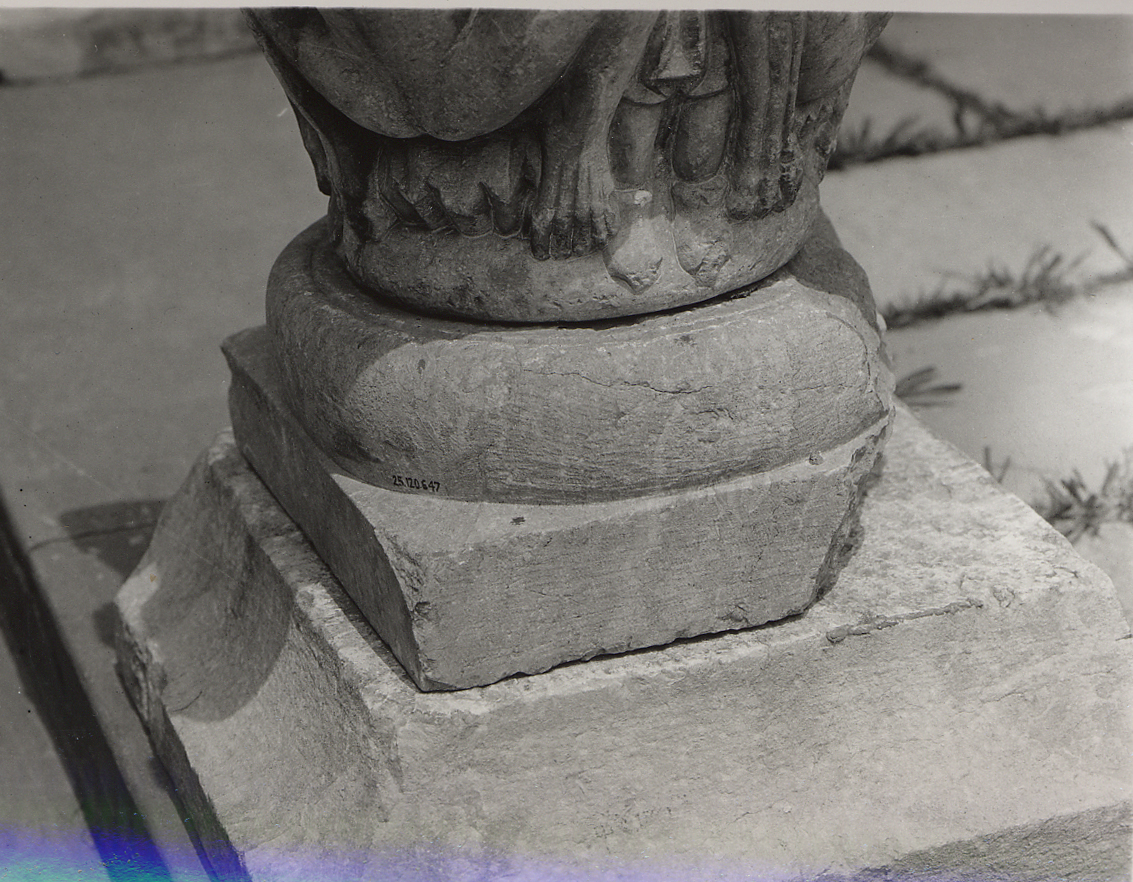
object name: column base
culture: catalan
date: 1130-1140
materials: marble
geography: france